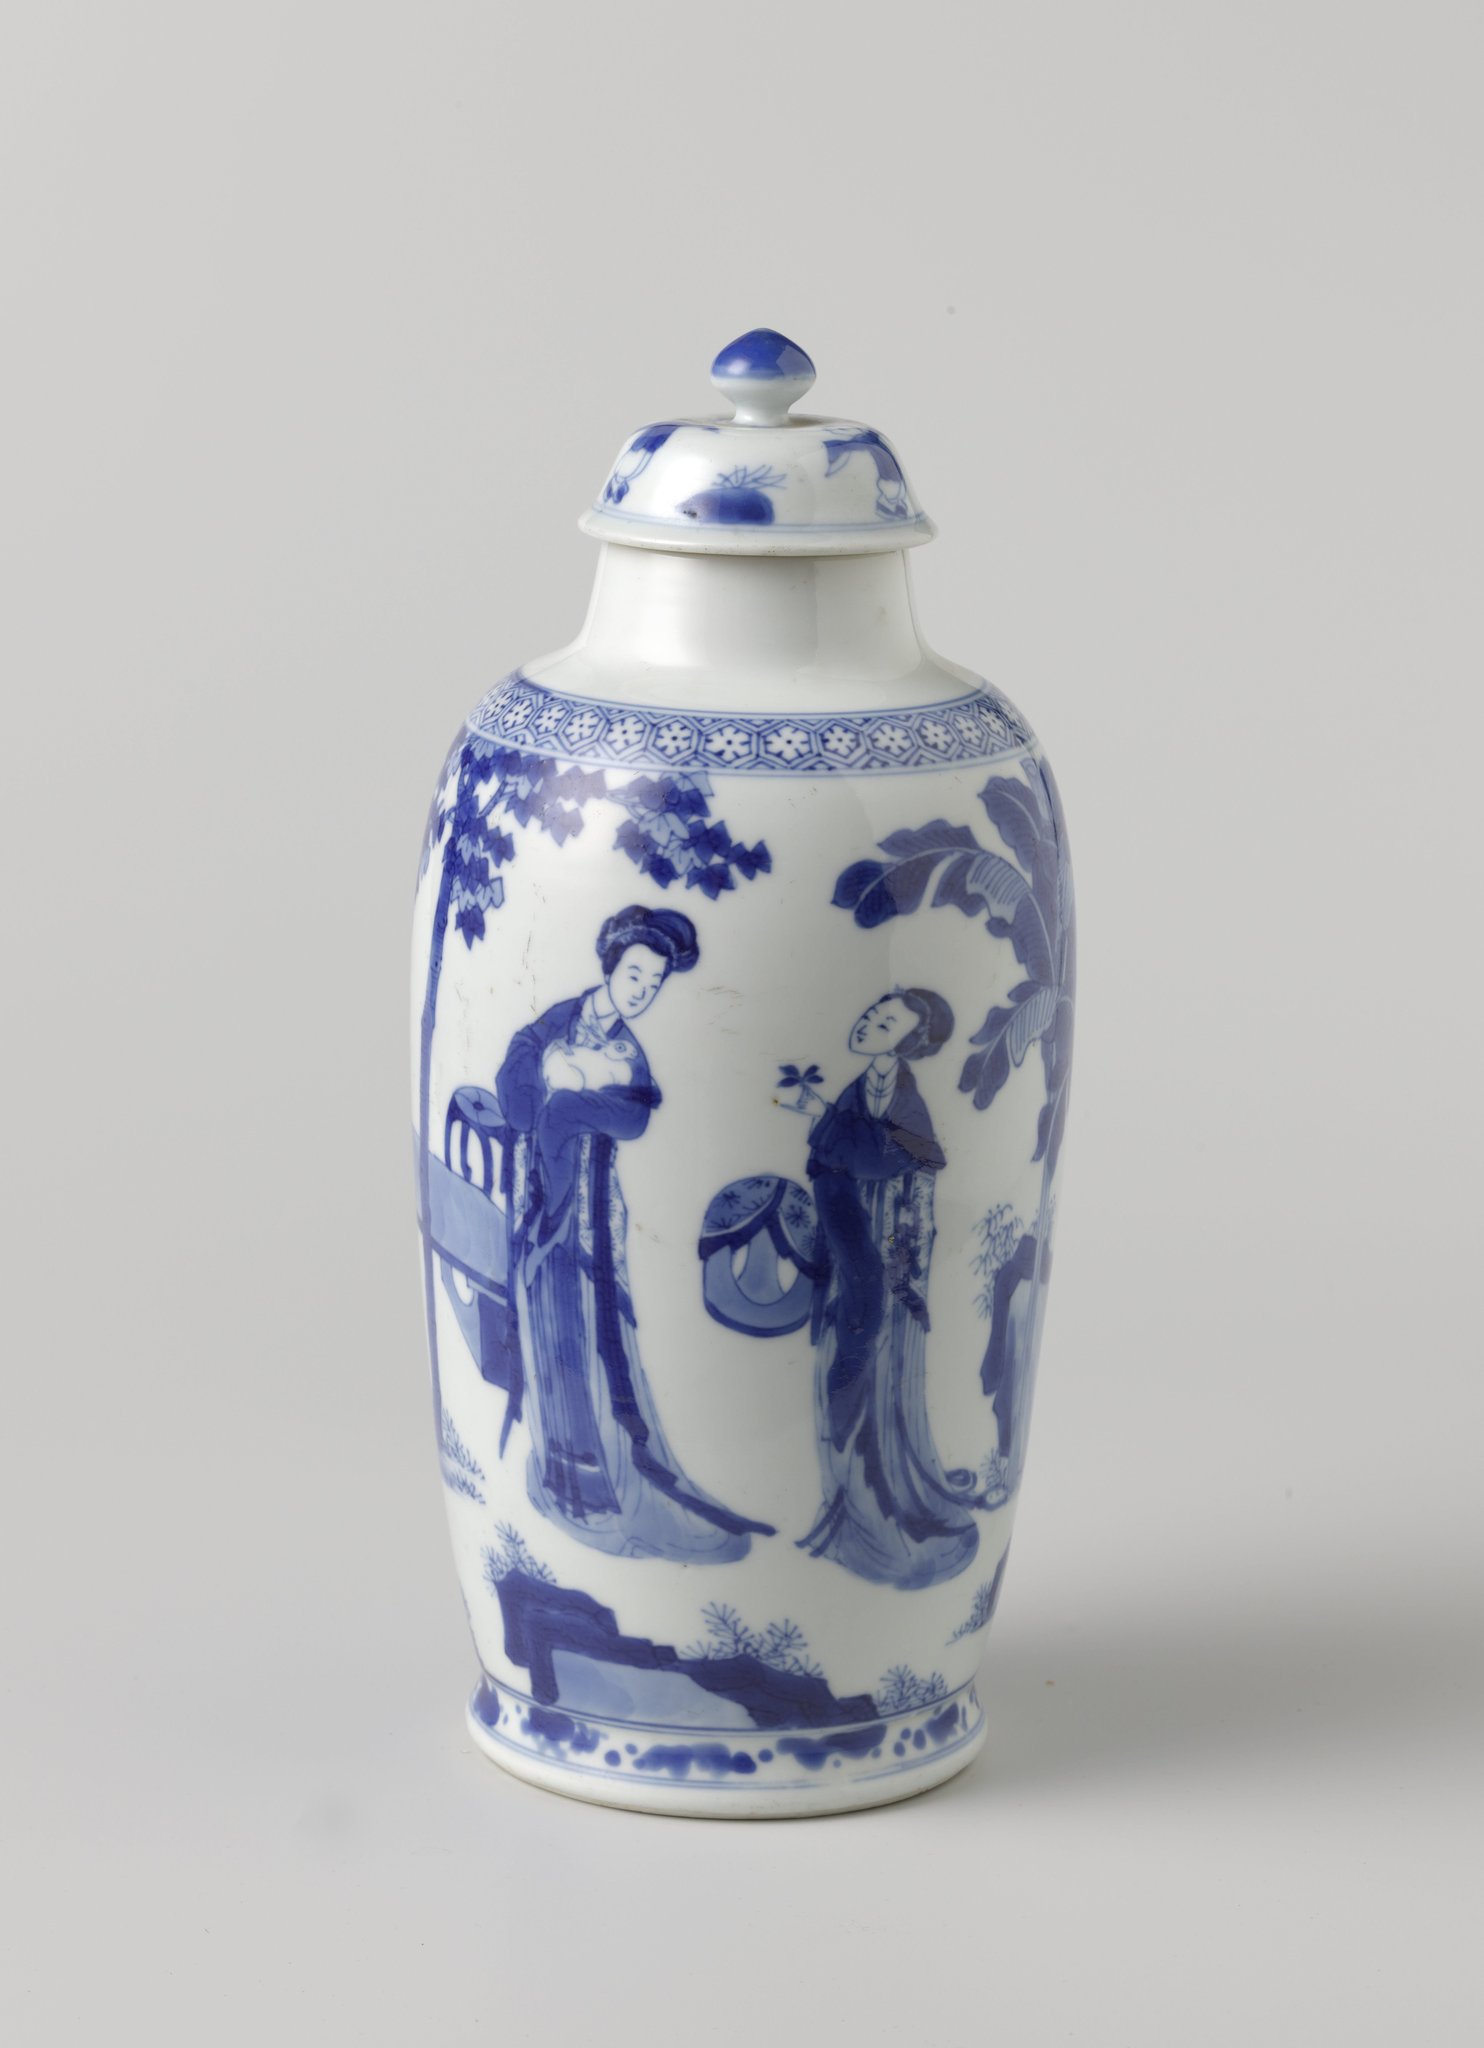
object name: covered jar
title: Ovoid covered jar with women in a garden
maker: Anonymous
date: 1680-1720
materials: cobalt, glaze, paint, porcelain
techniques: firing, turning, vitrification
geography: china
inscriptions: mark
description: Eivormige dekselpot van porselein, beschilderd in onderglazuur blauw. Op de wand een tafereel in een tuin met bomen, rotsen en planten: twee vrouwen (lange lijzen) kijkend naar een bloemenvaas op een tafel; twee vrouwen bij een tafel en kruk, één draagt een konijn, de andere heeft een twijgje in haar hand. Gemerkt op de onderzijde met een artemisiablad. Een barst in de nek. Blauw-wit.